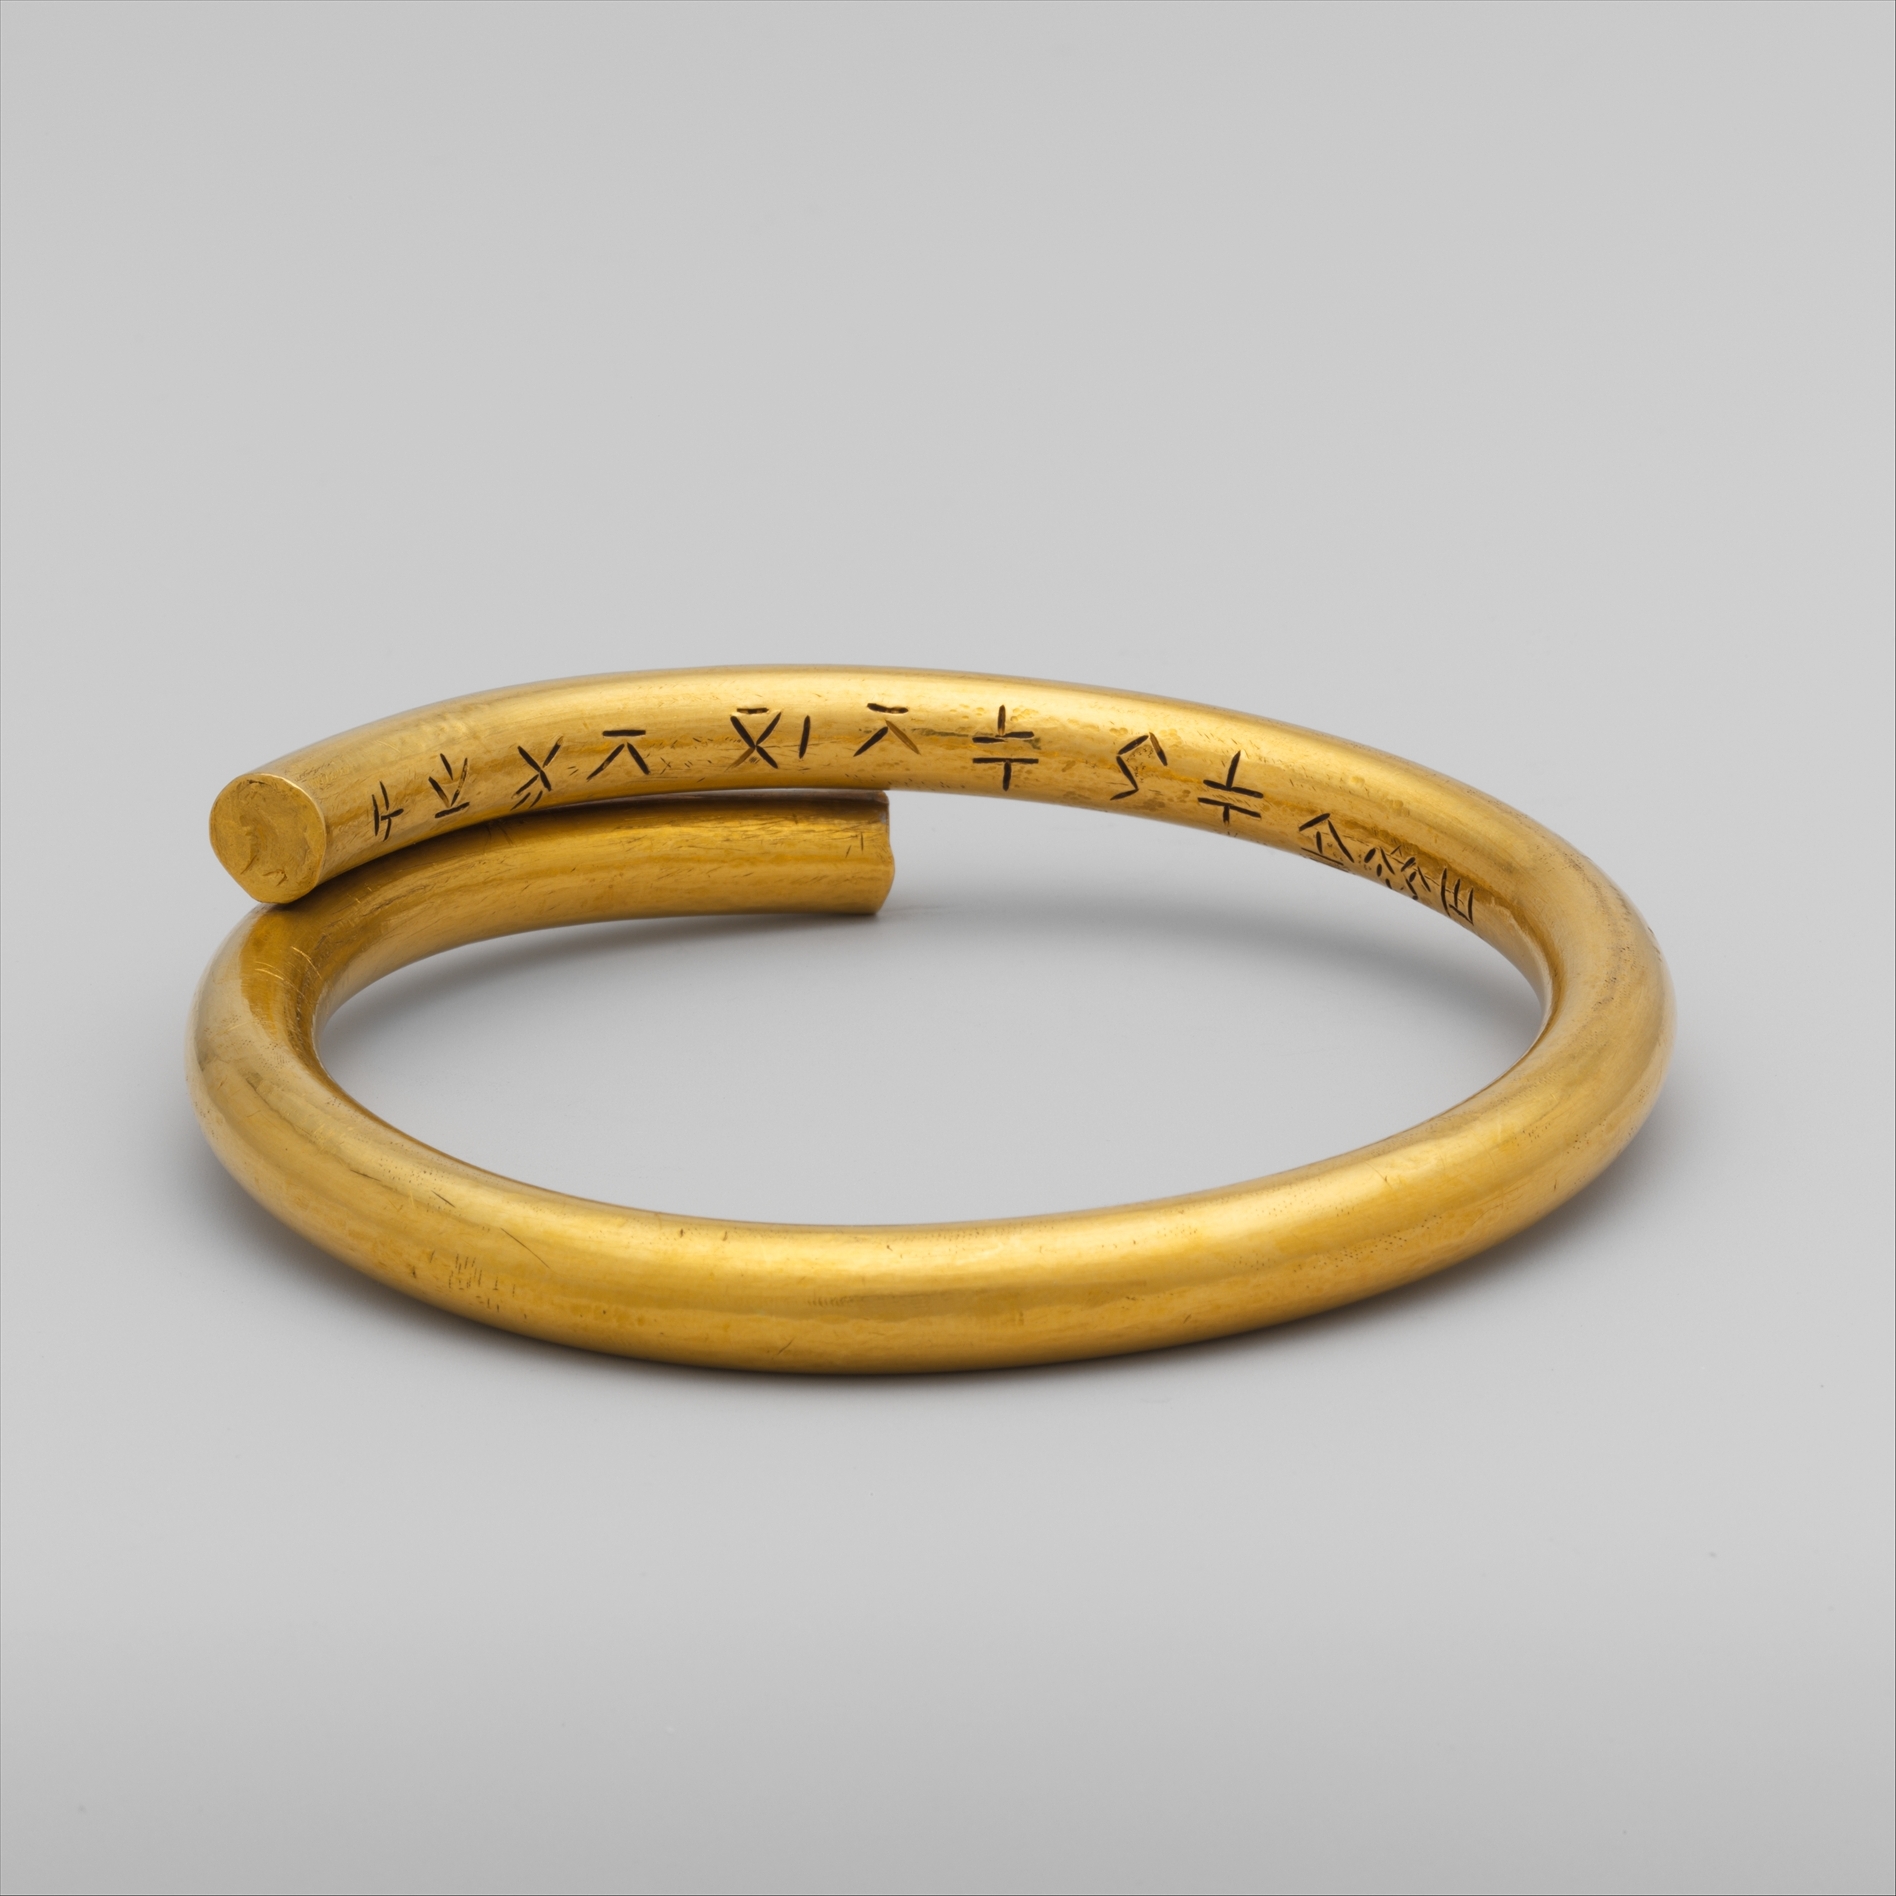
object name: bracelet inscribed with owner's name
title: Gold copy of a bracelet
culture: cypriot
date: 600-401 BCE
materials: gold